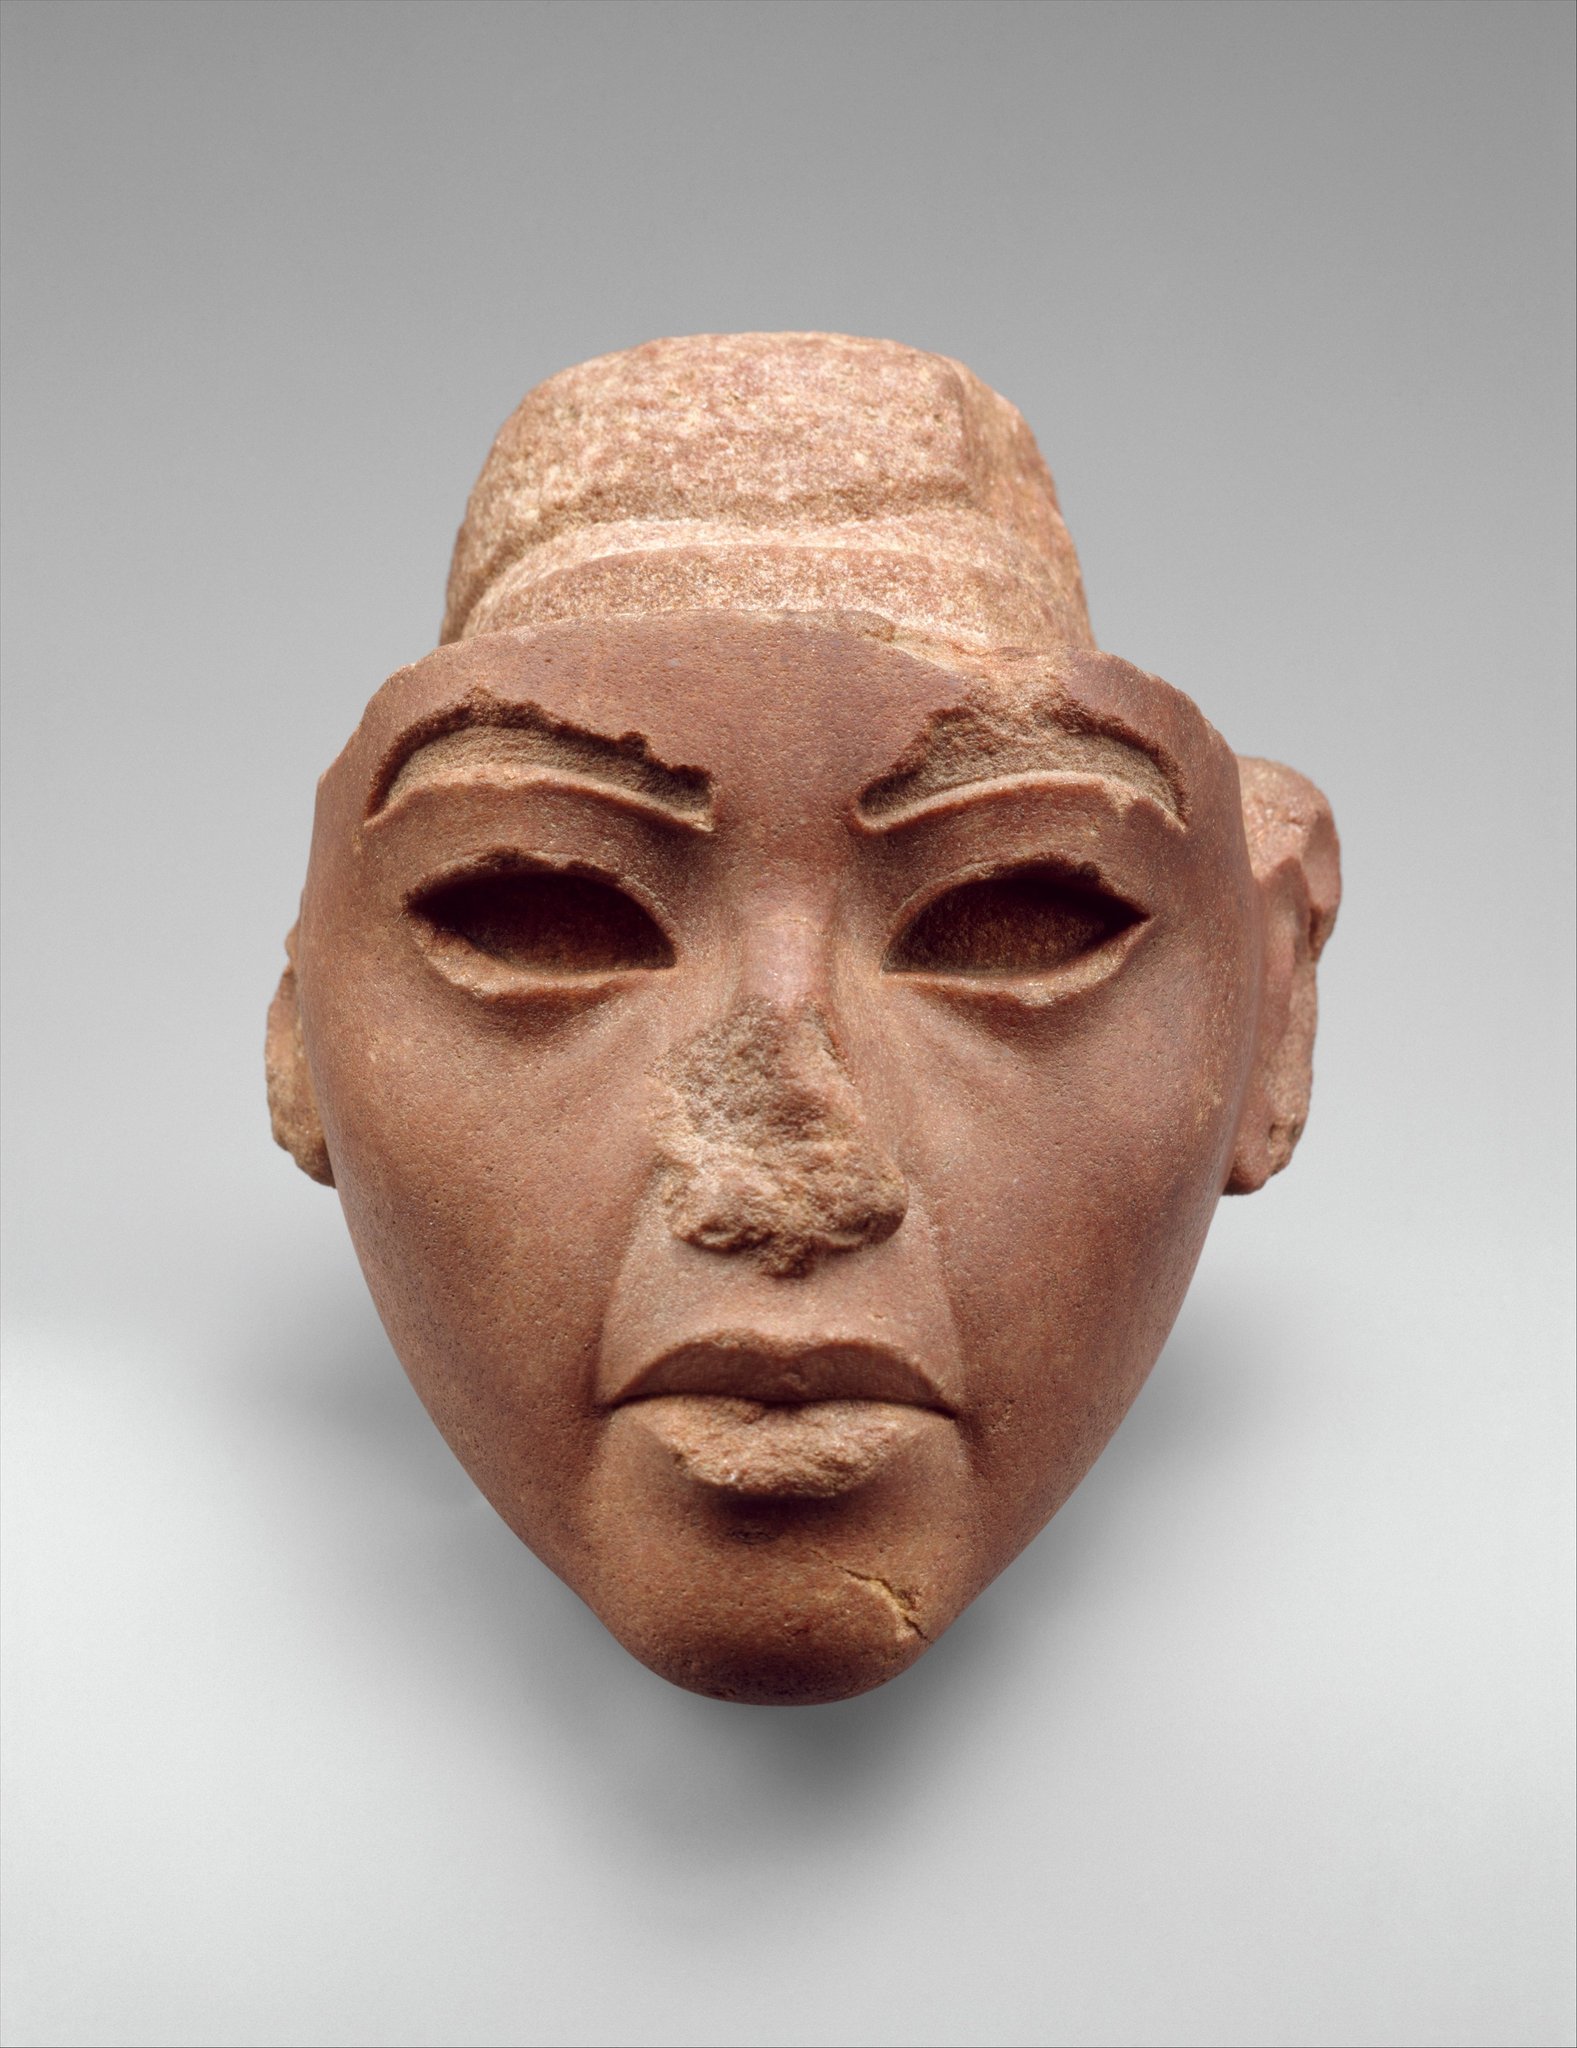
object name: head, queen tiye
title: Face from a Composite Statue, probably Queen Tiye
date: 1353-1336 BCE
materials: quartzite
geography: middle egypt